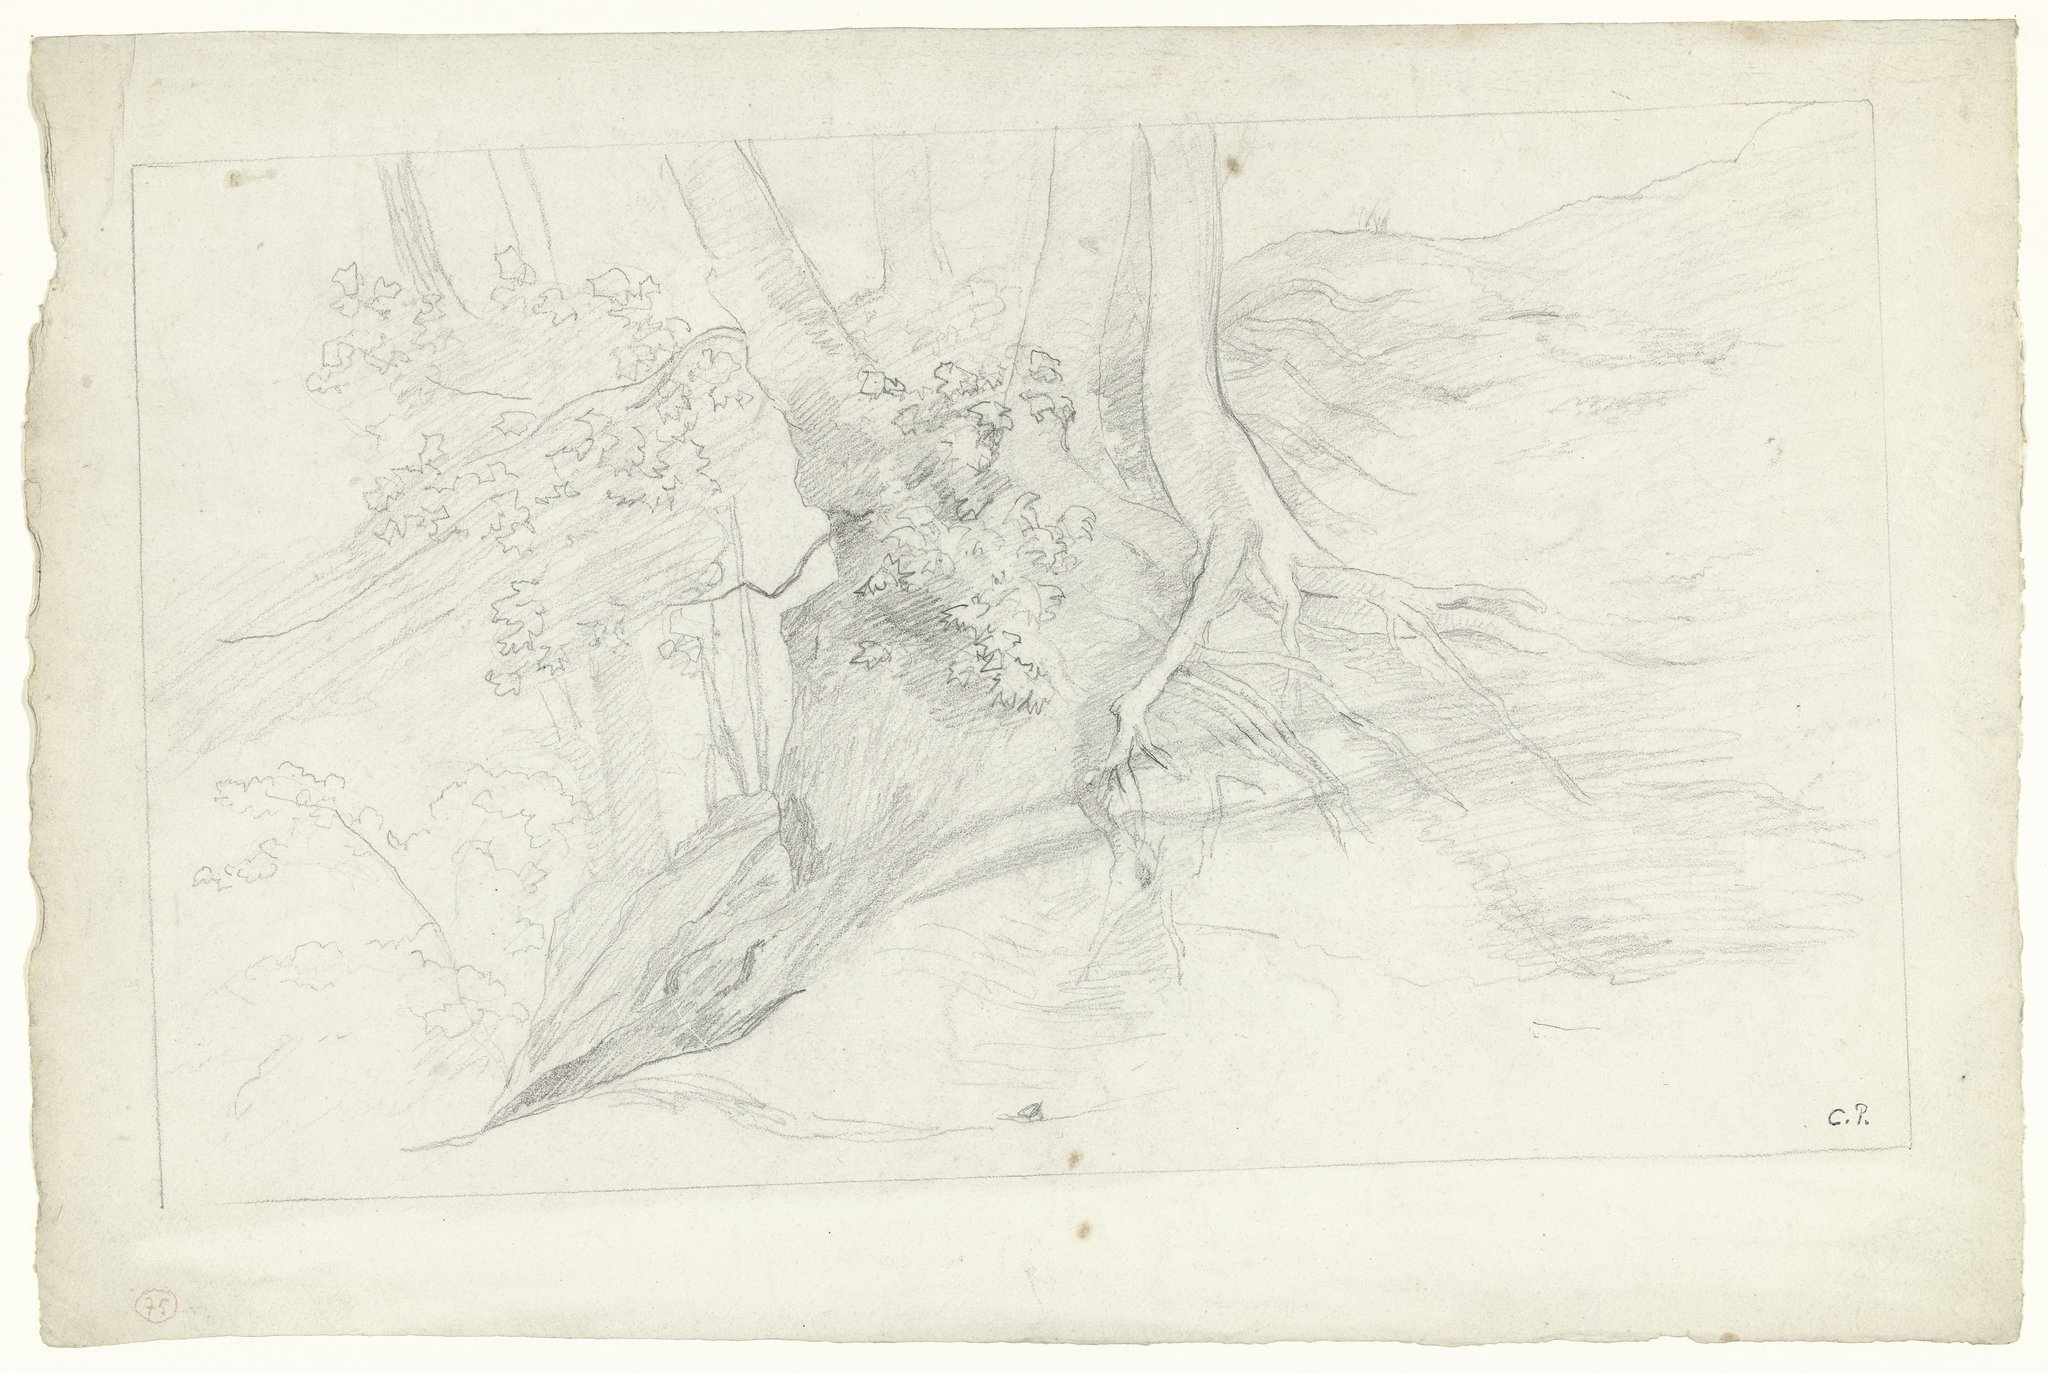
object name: drawing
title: Boomgroep met wortels boven de grond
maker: camille jacob pissarro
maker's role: draughtsman, print maker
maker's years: 1830-1903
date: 1840-1903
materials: chalk, paper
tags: groups of trees